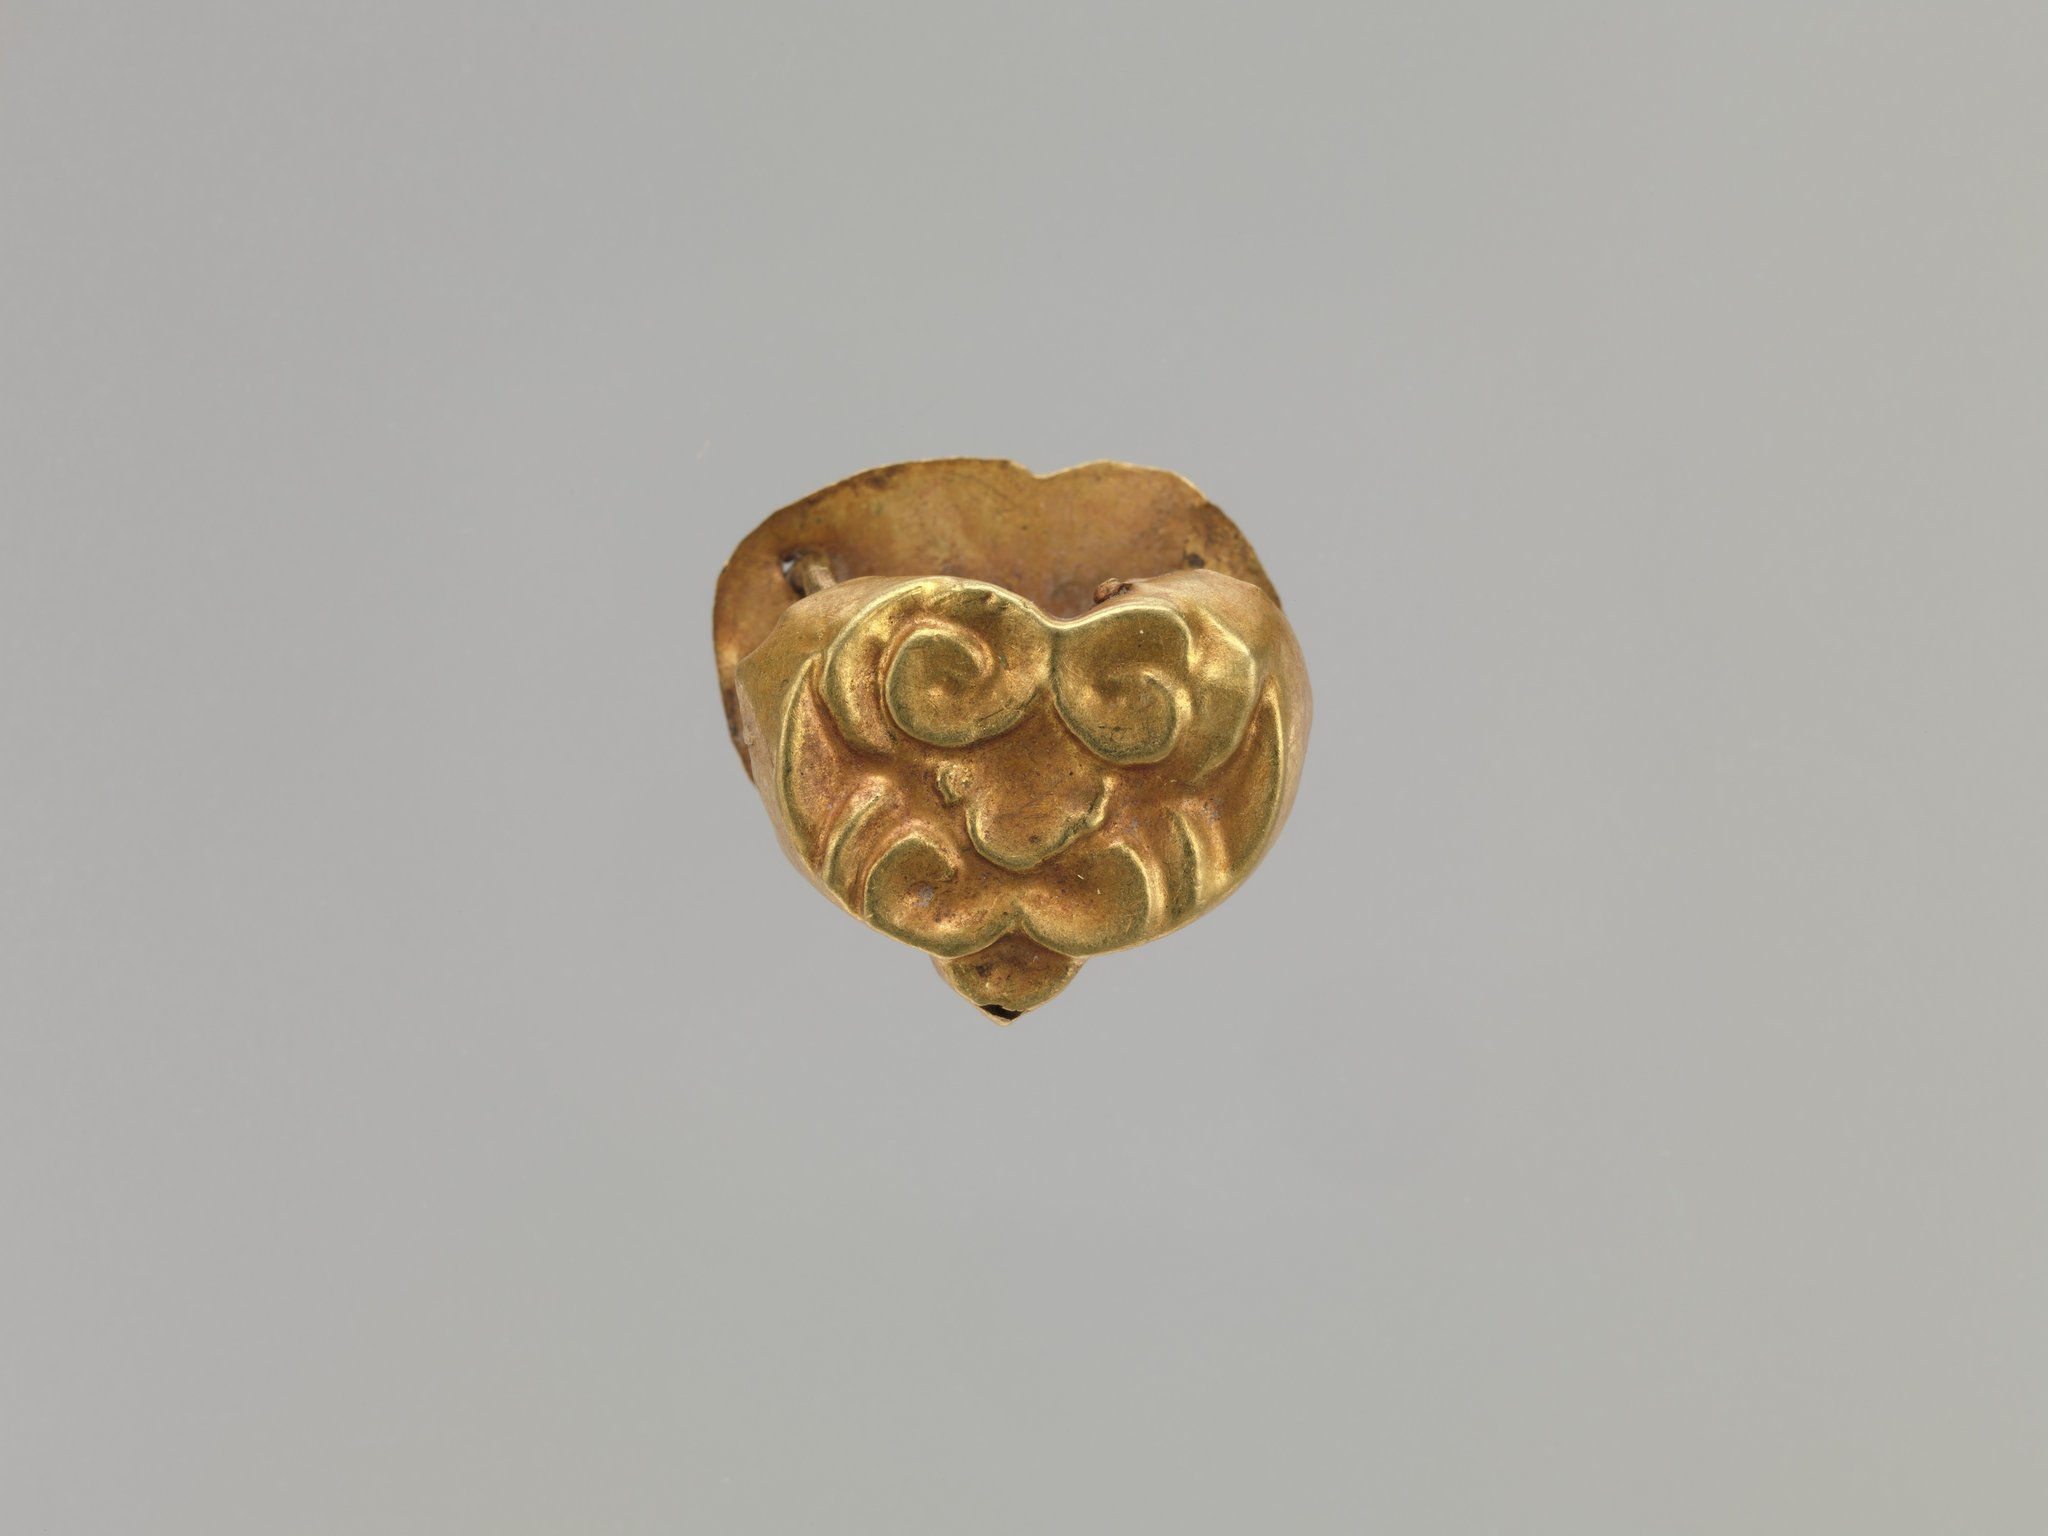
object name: attachment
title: Heart-Shaped Plaque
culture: chinese or central asian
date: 601-900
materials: gold